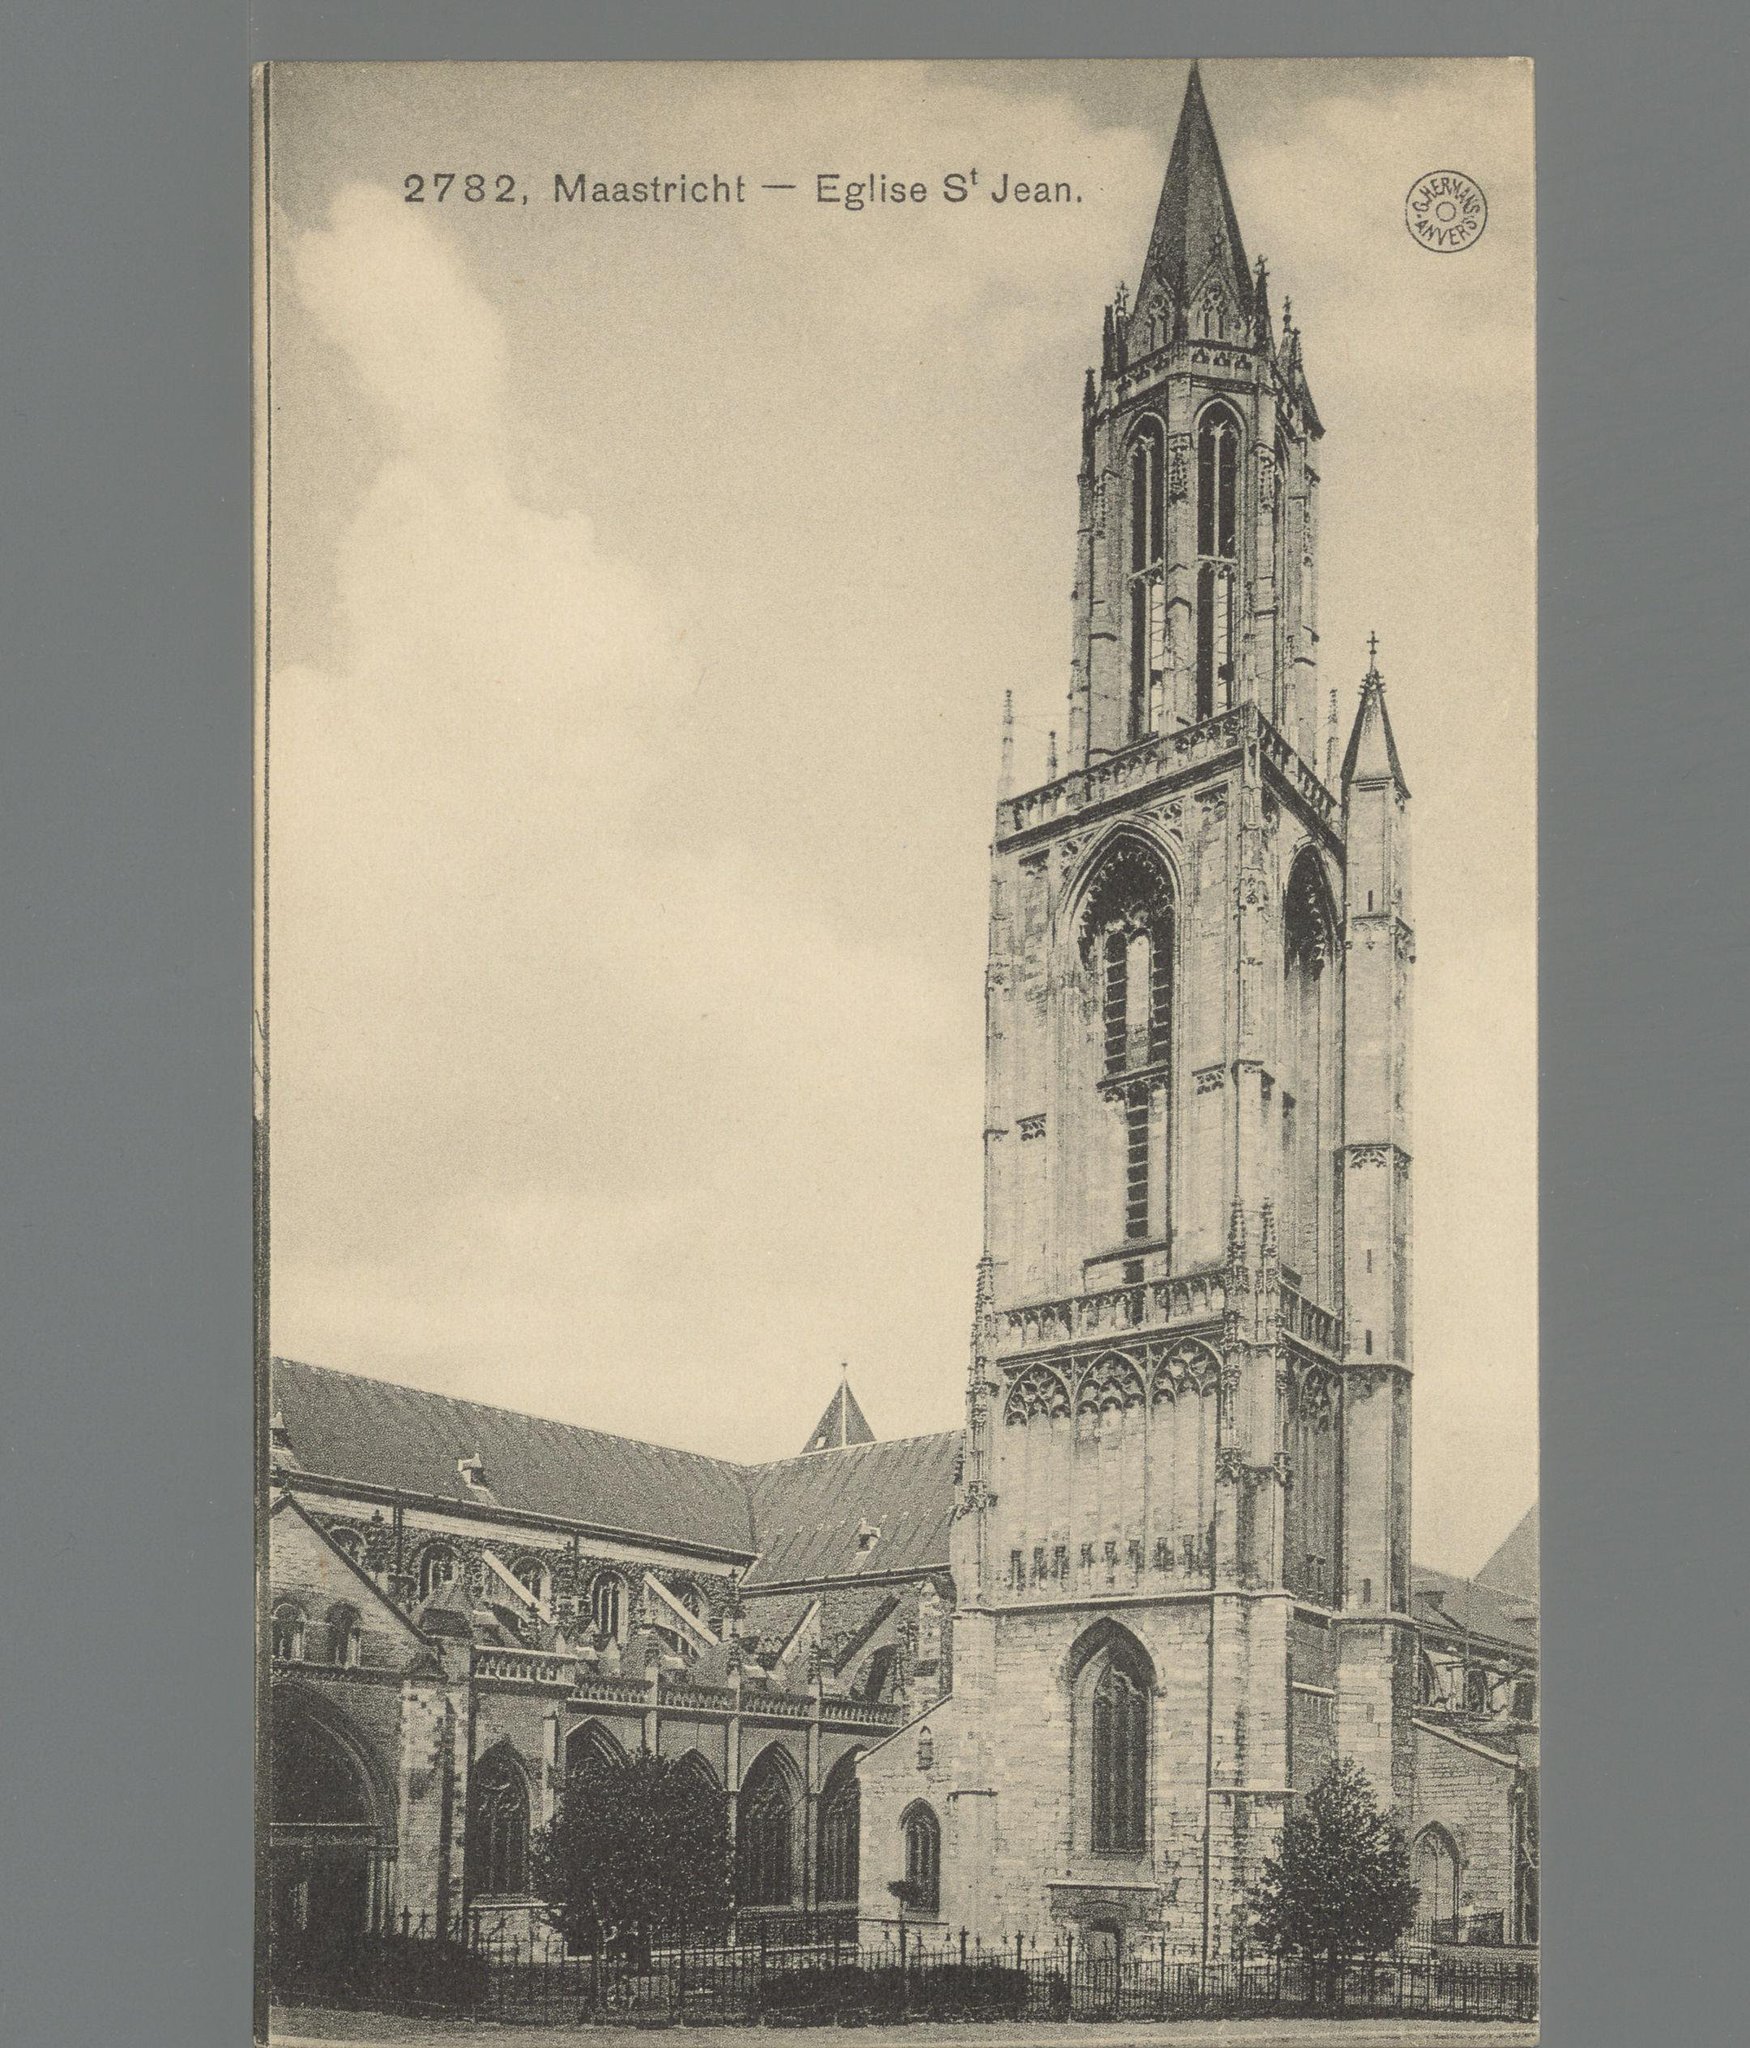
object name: ansichtkaart, prentbriefkaart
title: Maastricht - Eglise St Jean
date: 1906-1930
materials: cardboard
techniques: photograph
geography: maastricht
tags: church (exterior)